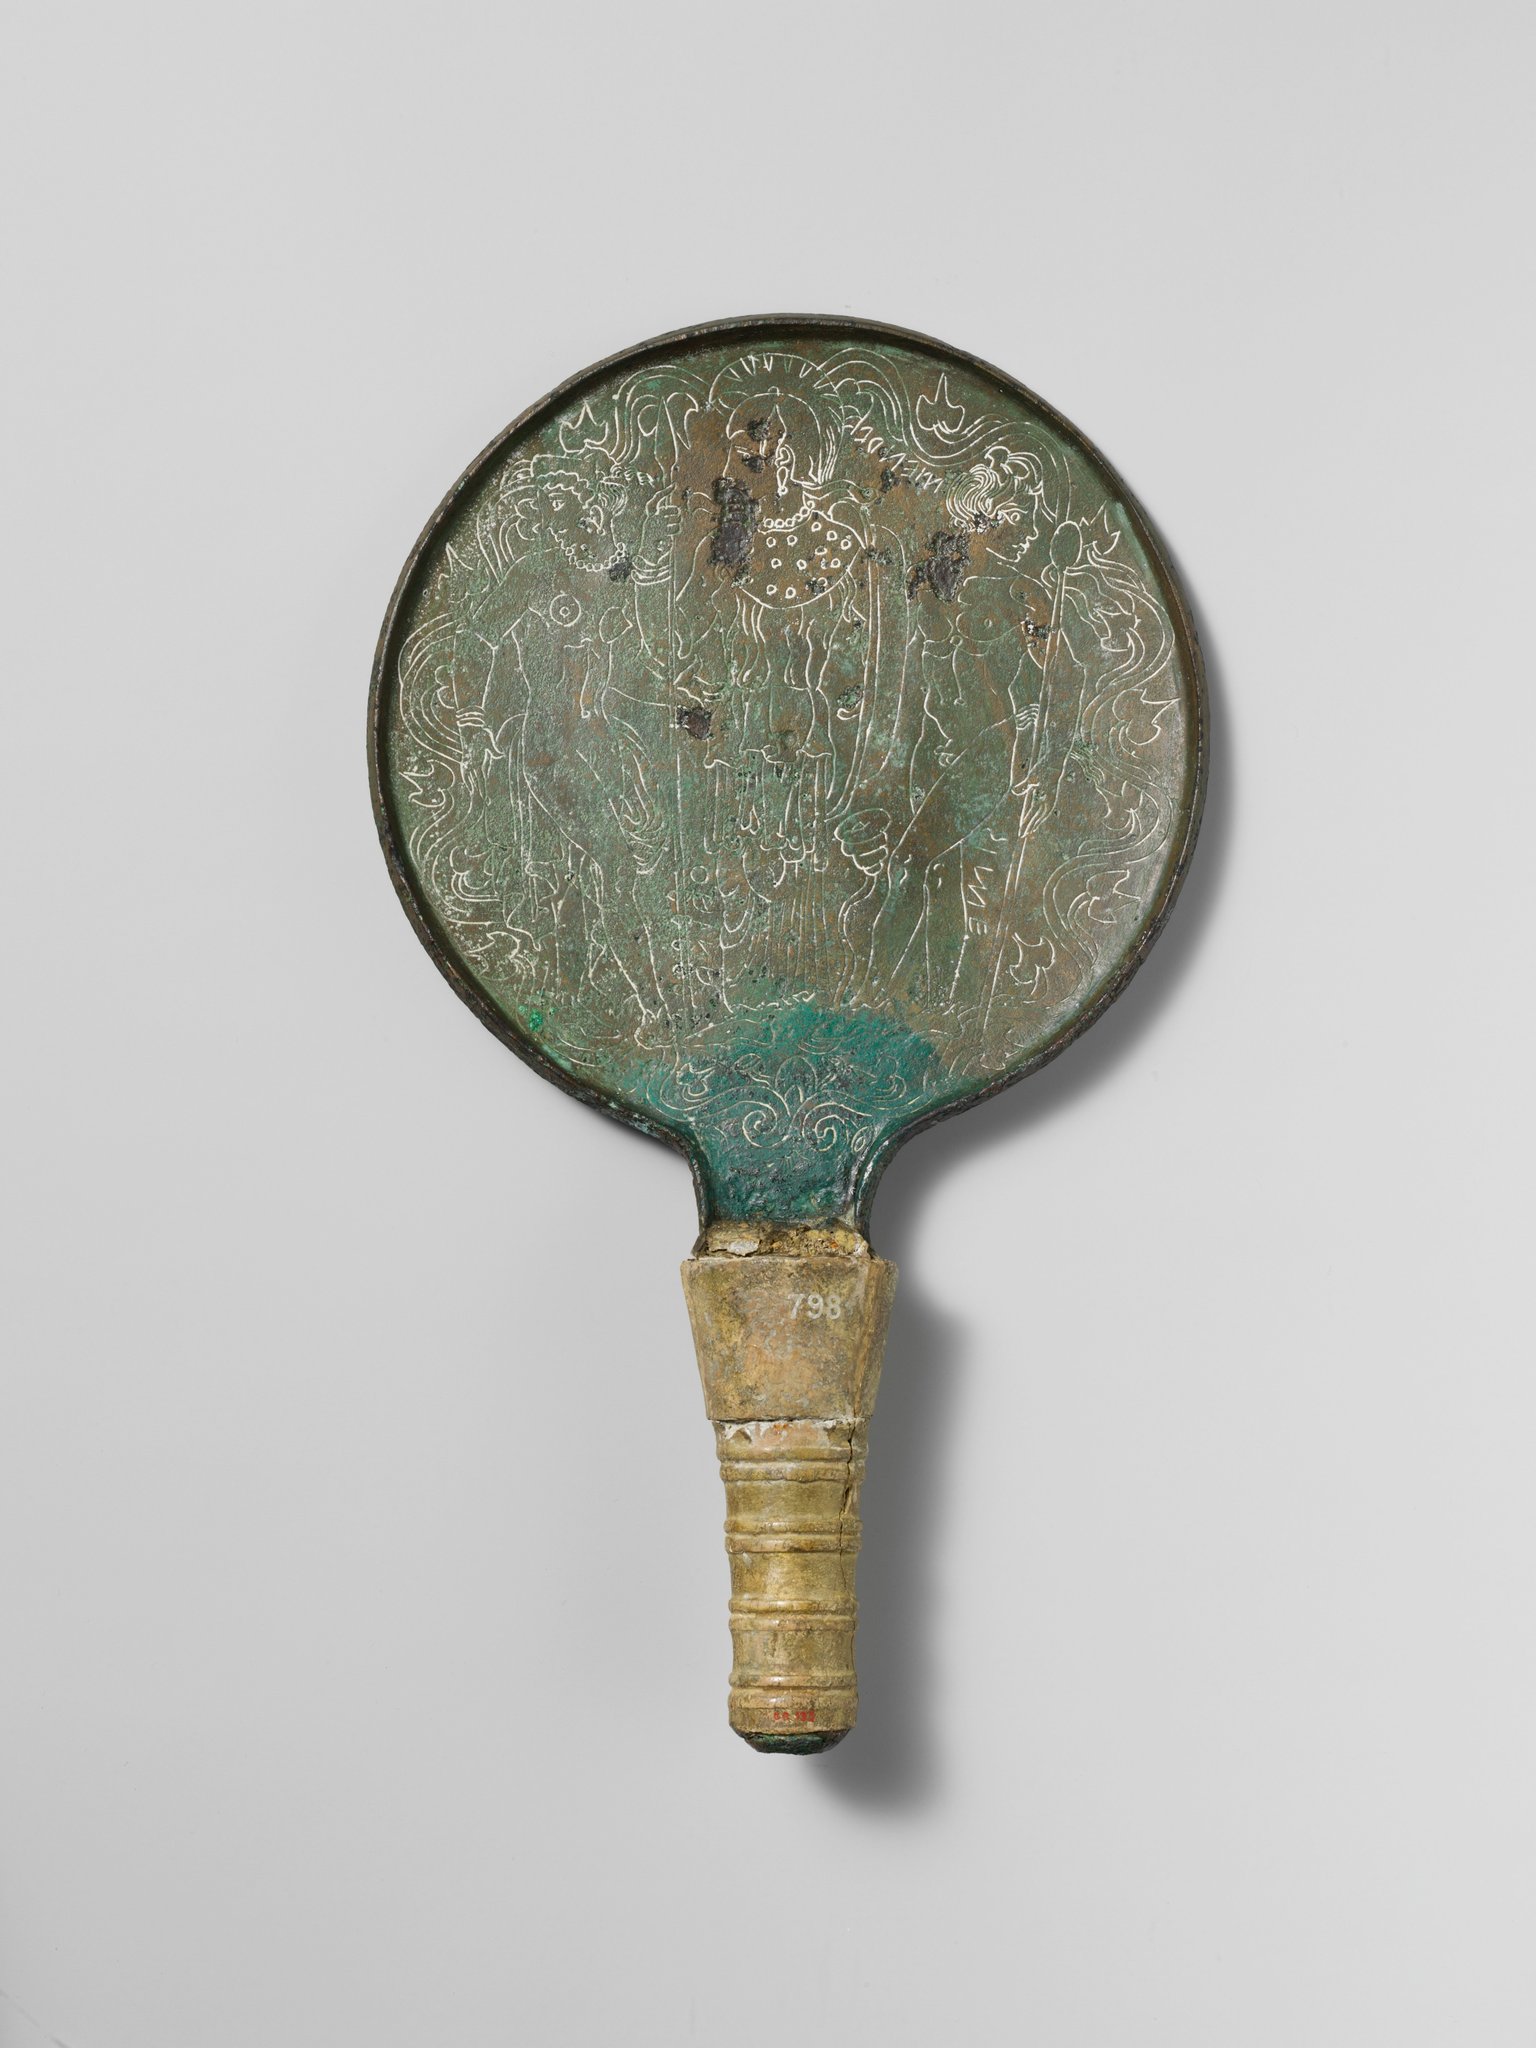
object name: mirror with athena, thalna, sime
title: Bronze mirror with ivory handle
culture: etruscan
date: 334-301 BCE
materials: bronze, ivory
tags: male nudes,female nudes